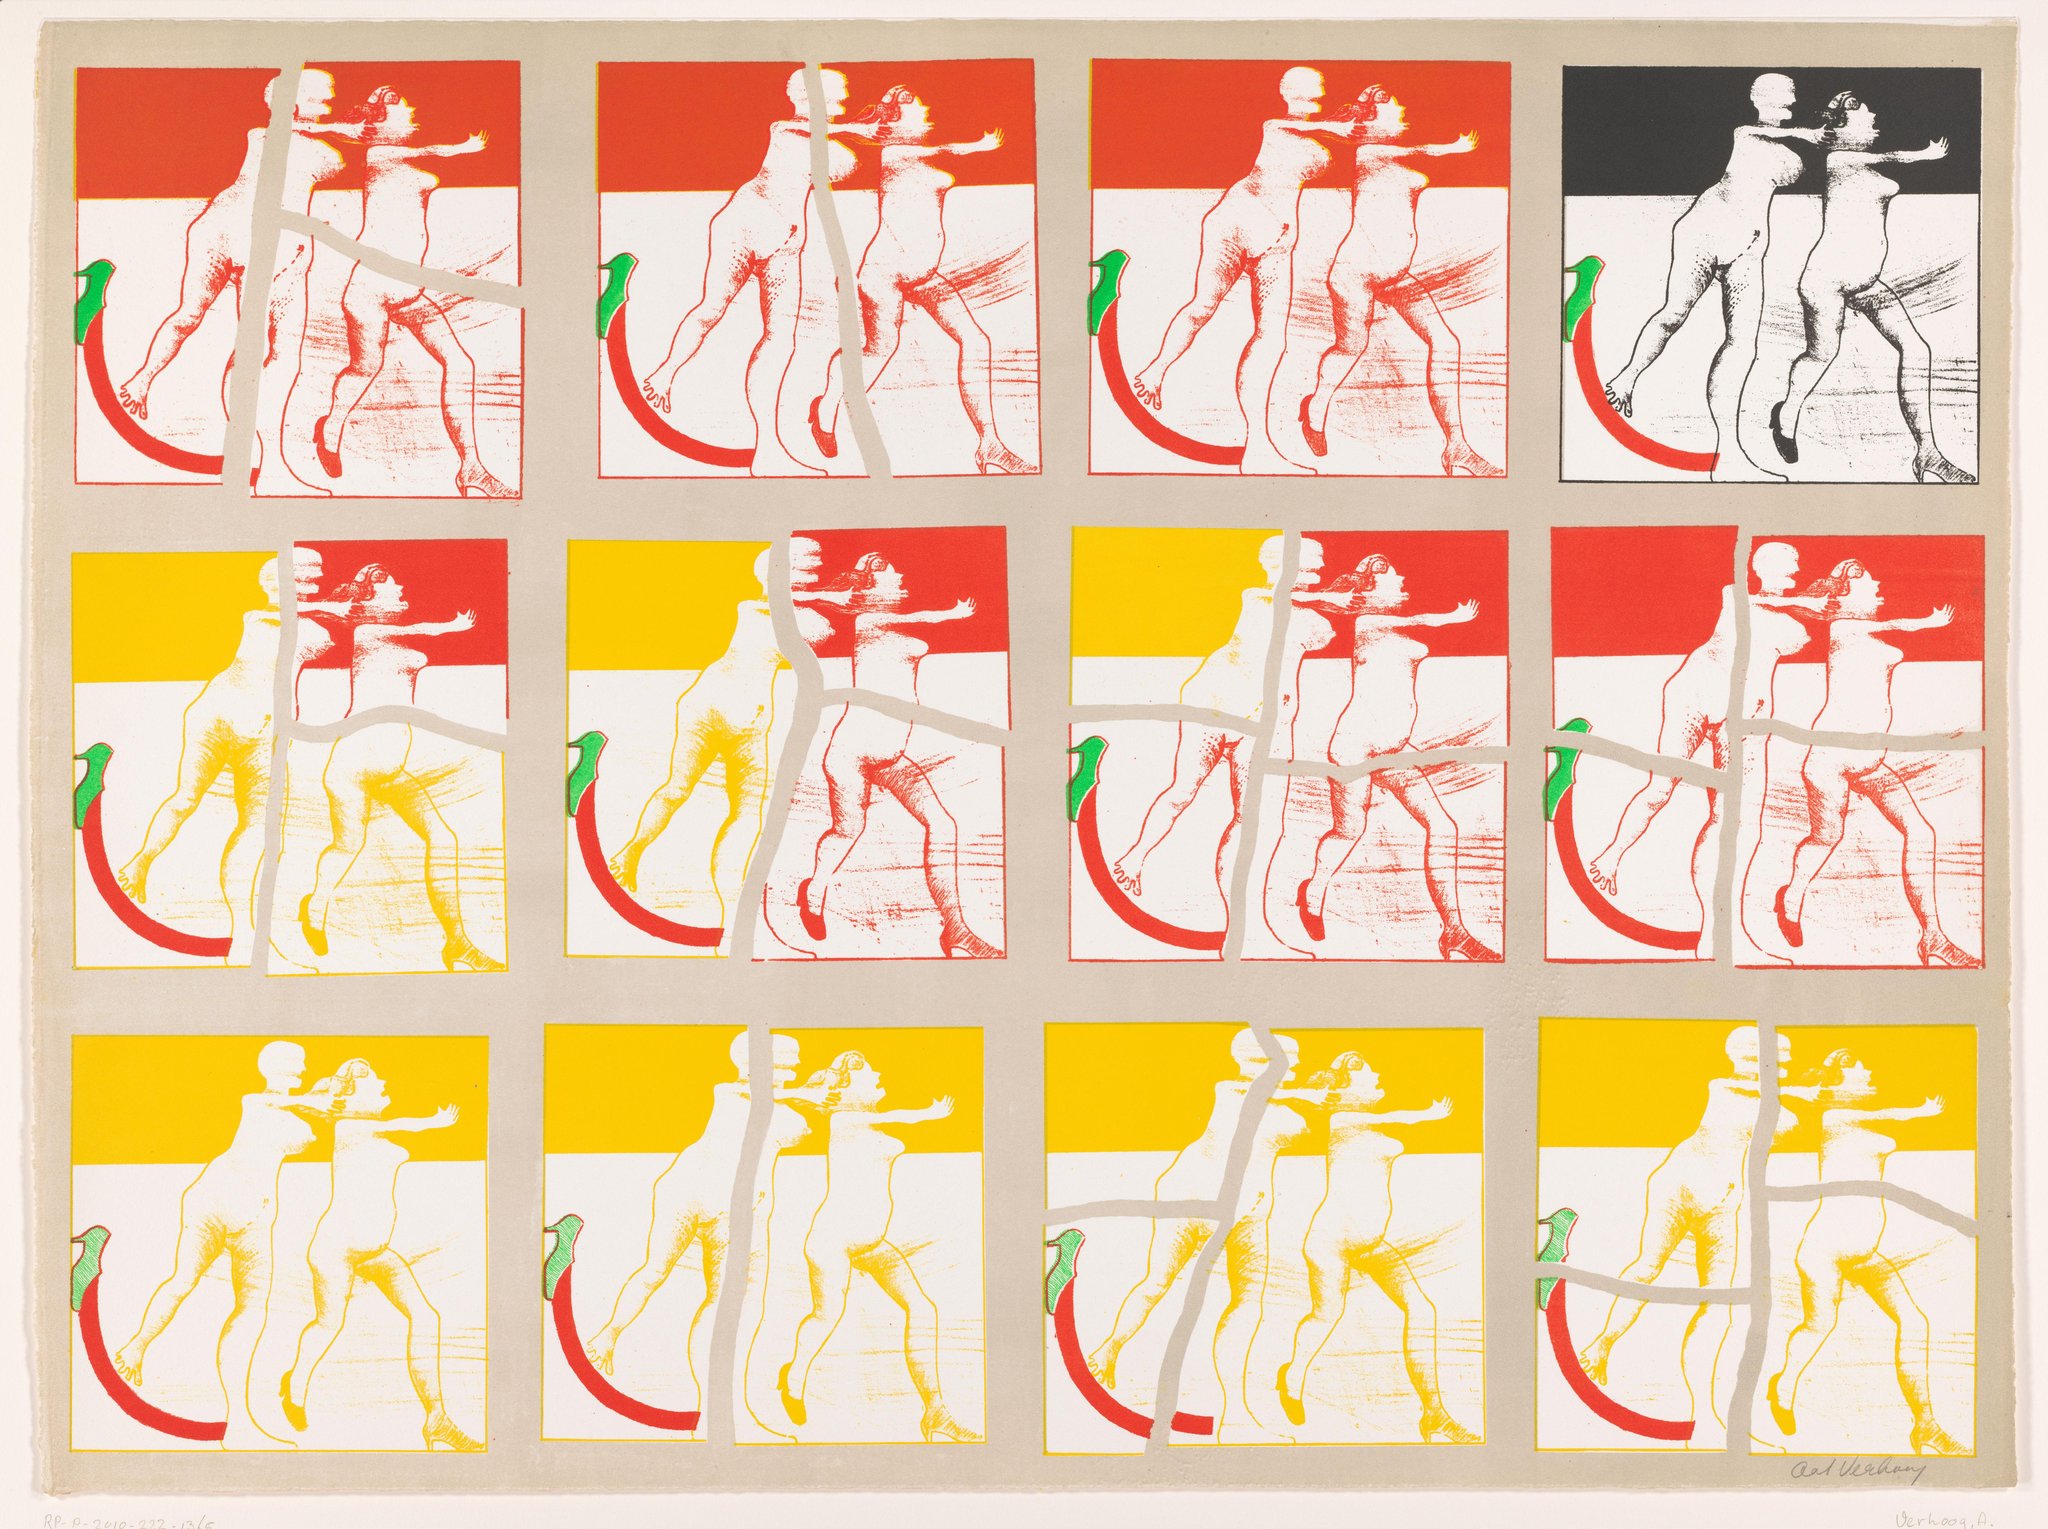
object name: print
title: Twee naakten (twaalf keer)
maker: aat verhoog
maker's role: print maker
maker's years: 1933-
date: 1966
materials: paper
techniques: lithograph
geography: amsterdam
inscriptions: signature: ‘Aat Verhoog’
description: Twaalf nagenoeg identieke voorstellingen van twee naakten, waarvan bij sommige wordt gesuggereerd dat er scheuren lopen door het papier waarop ze zijn weergegeven.